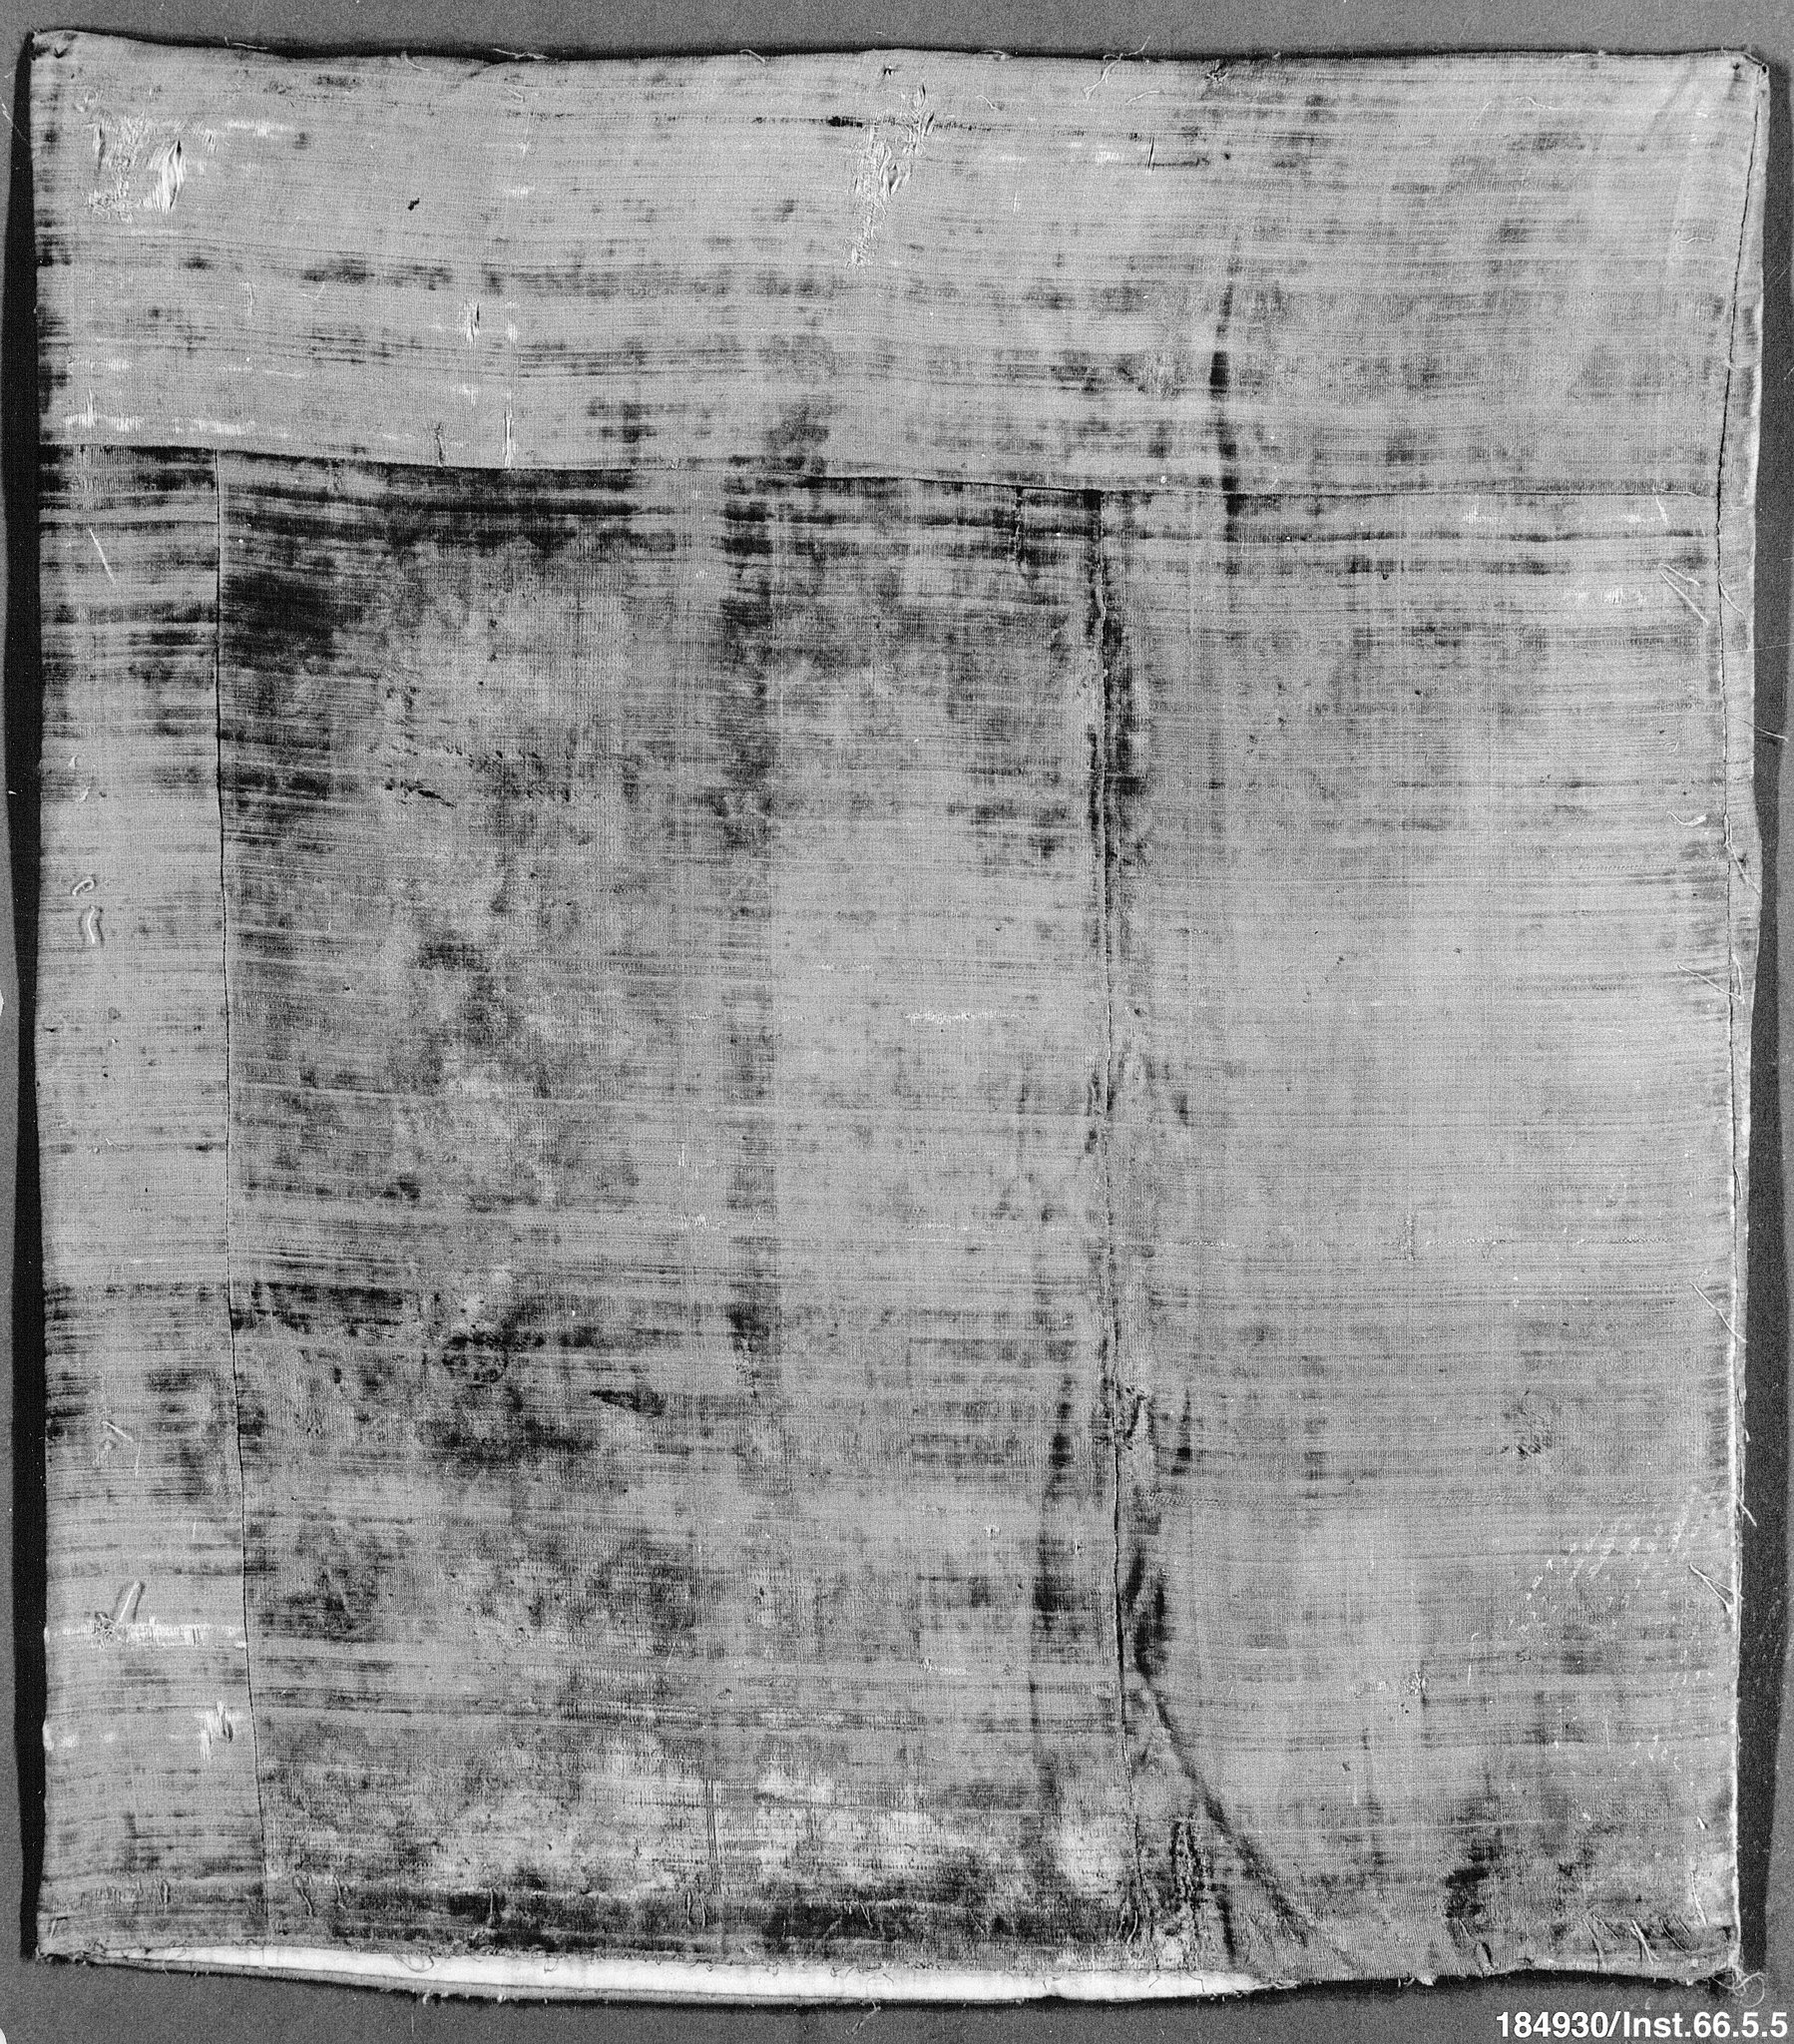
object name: pillow cover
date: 1701-1800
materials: silk